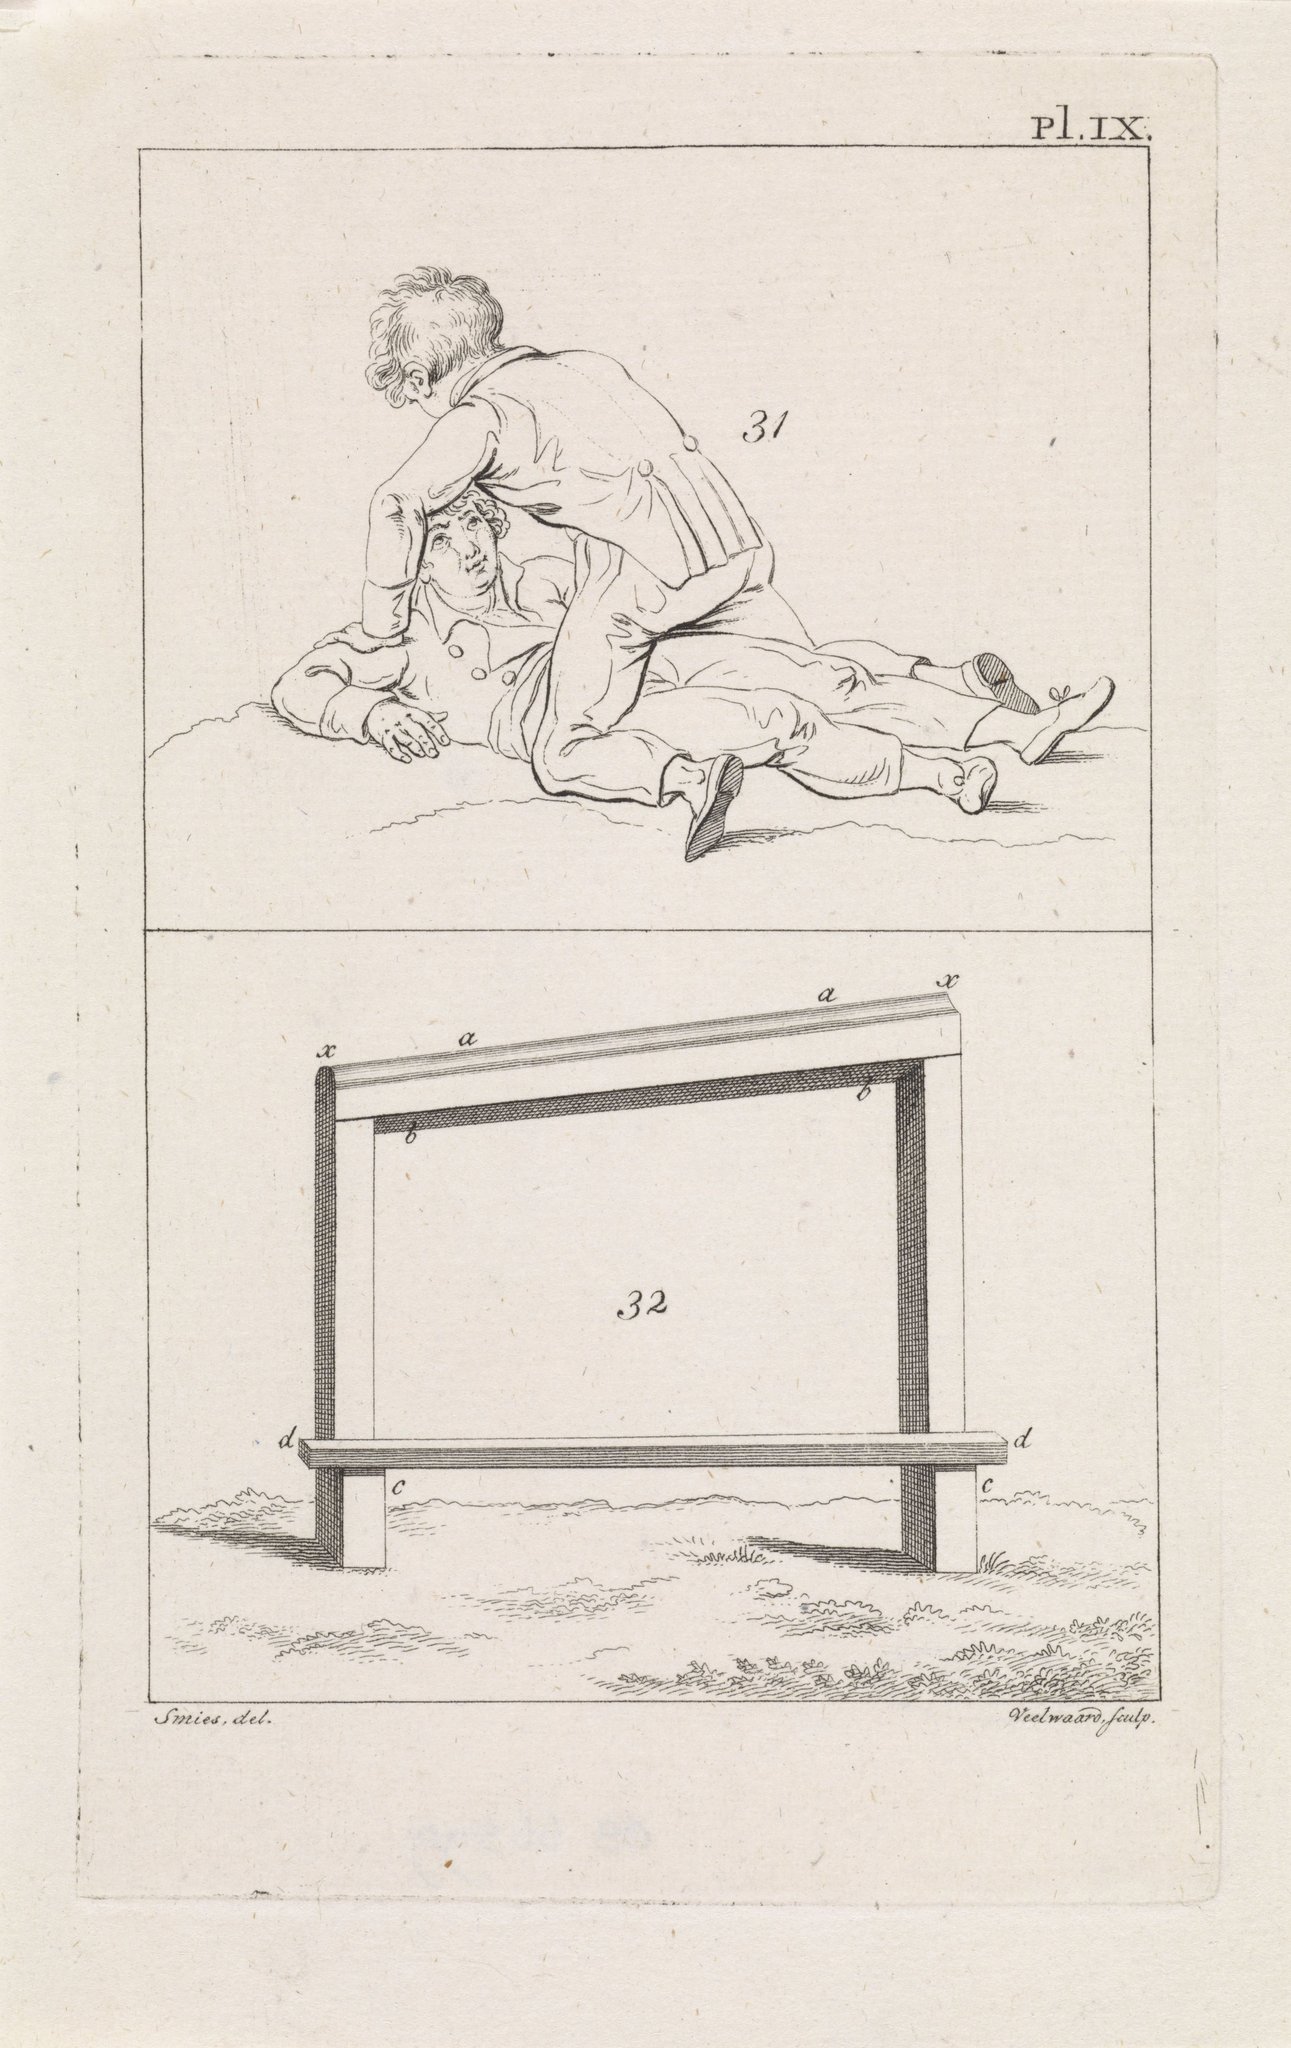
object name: print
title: Lichamelijke oefeningen; worstelen C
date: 1806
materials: paper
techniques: etching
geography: amsterdam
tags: fighting contest (sport)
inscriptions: collector's mark: Lugt 2228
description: Prent vermoedelijk ook gebruikt als boekillustratie in: Geuns, Jan van. [naar J.C.F. Gutsmuths]. Volledig leerstelsel van kunstmatige ligchaams-oefeningen. Eene bijdrage tot de opvoeding der Jeugd. 2 dln. Leiden en Haarlem: 1806-1812.